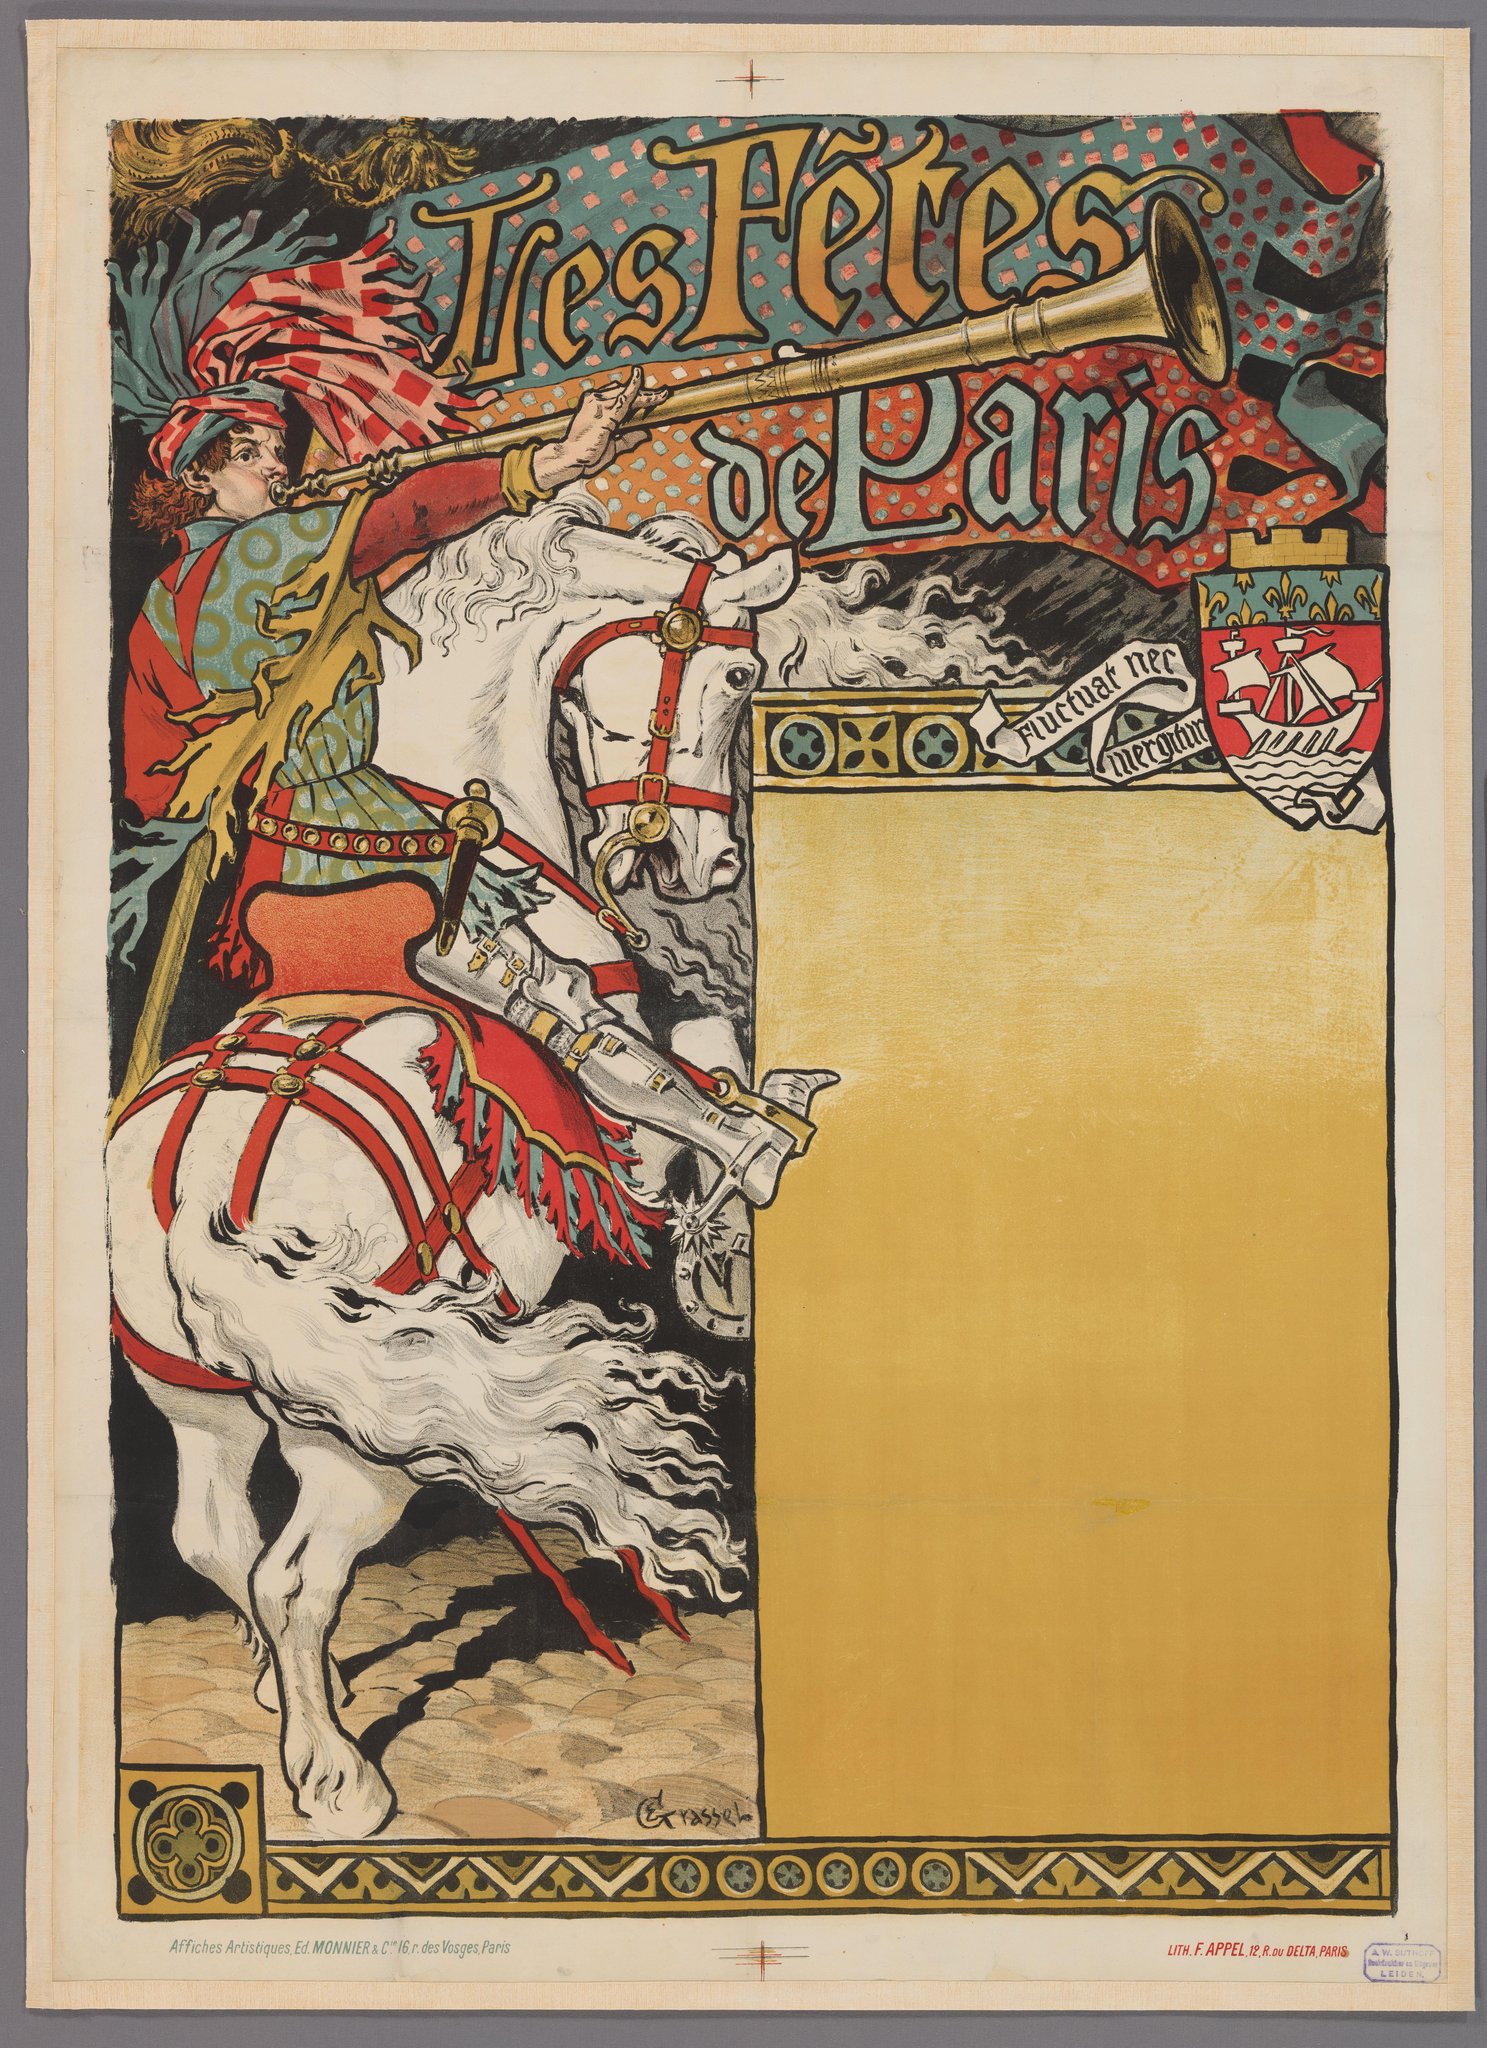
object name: print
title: Affiche voor 'Les fêtes de Paris'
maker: eugène grasset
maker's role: print maker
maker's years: 1841-1917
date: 1885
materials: paper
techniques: lithograph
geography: paris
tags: horse, herald, paris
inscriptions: collector's mark: ‘A.W. Sijthoff/ boekdrukker en uitgever/ Leiden.’, collector's mark: Lugt 2760, collector's mark: Lugt 2888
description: Met een heraut met trompet op een wit paard, met rechts een geel vlak dat ingevuld kan worden.